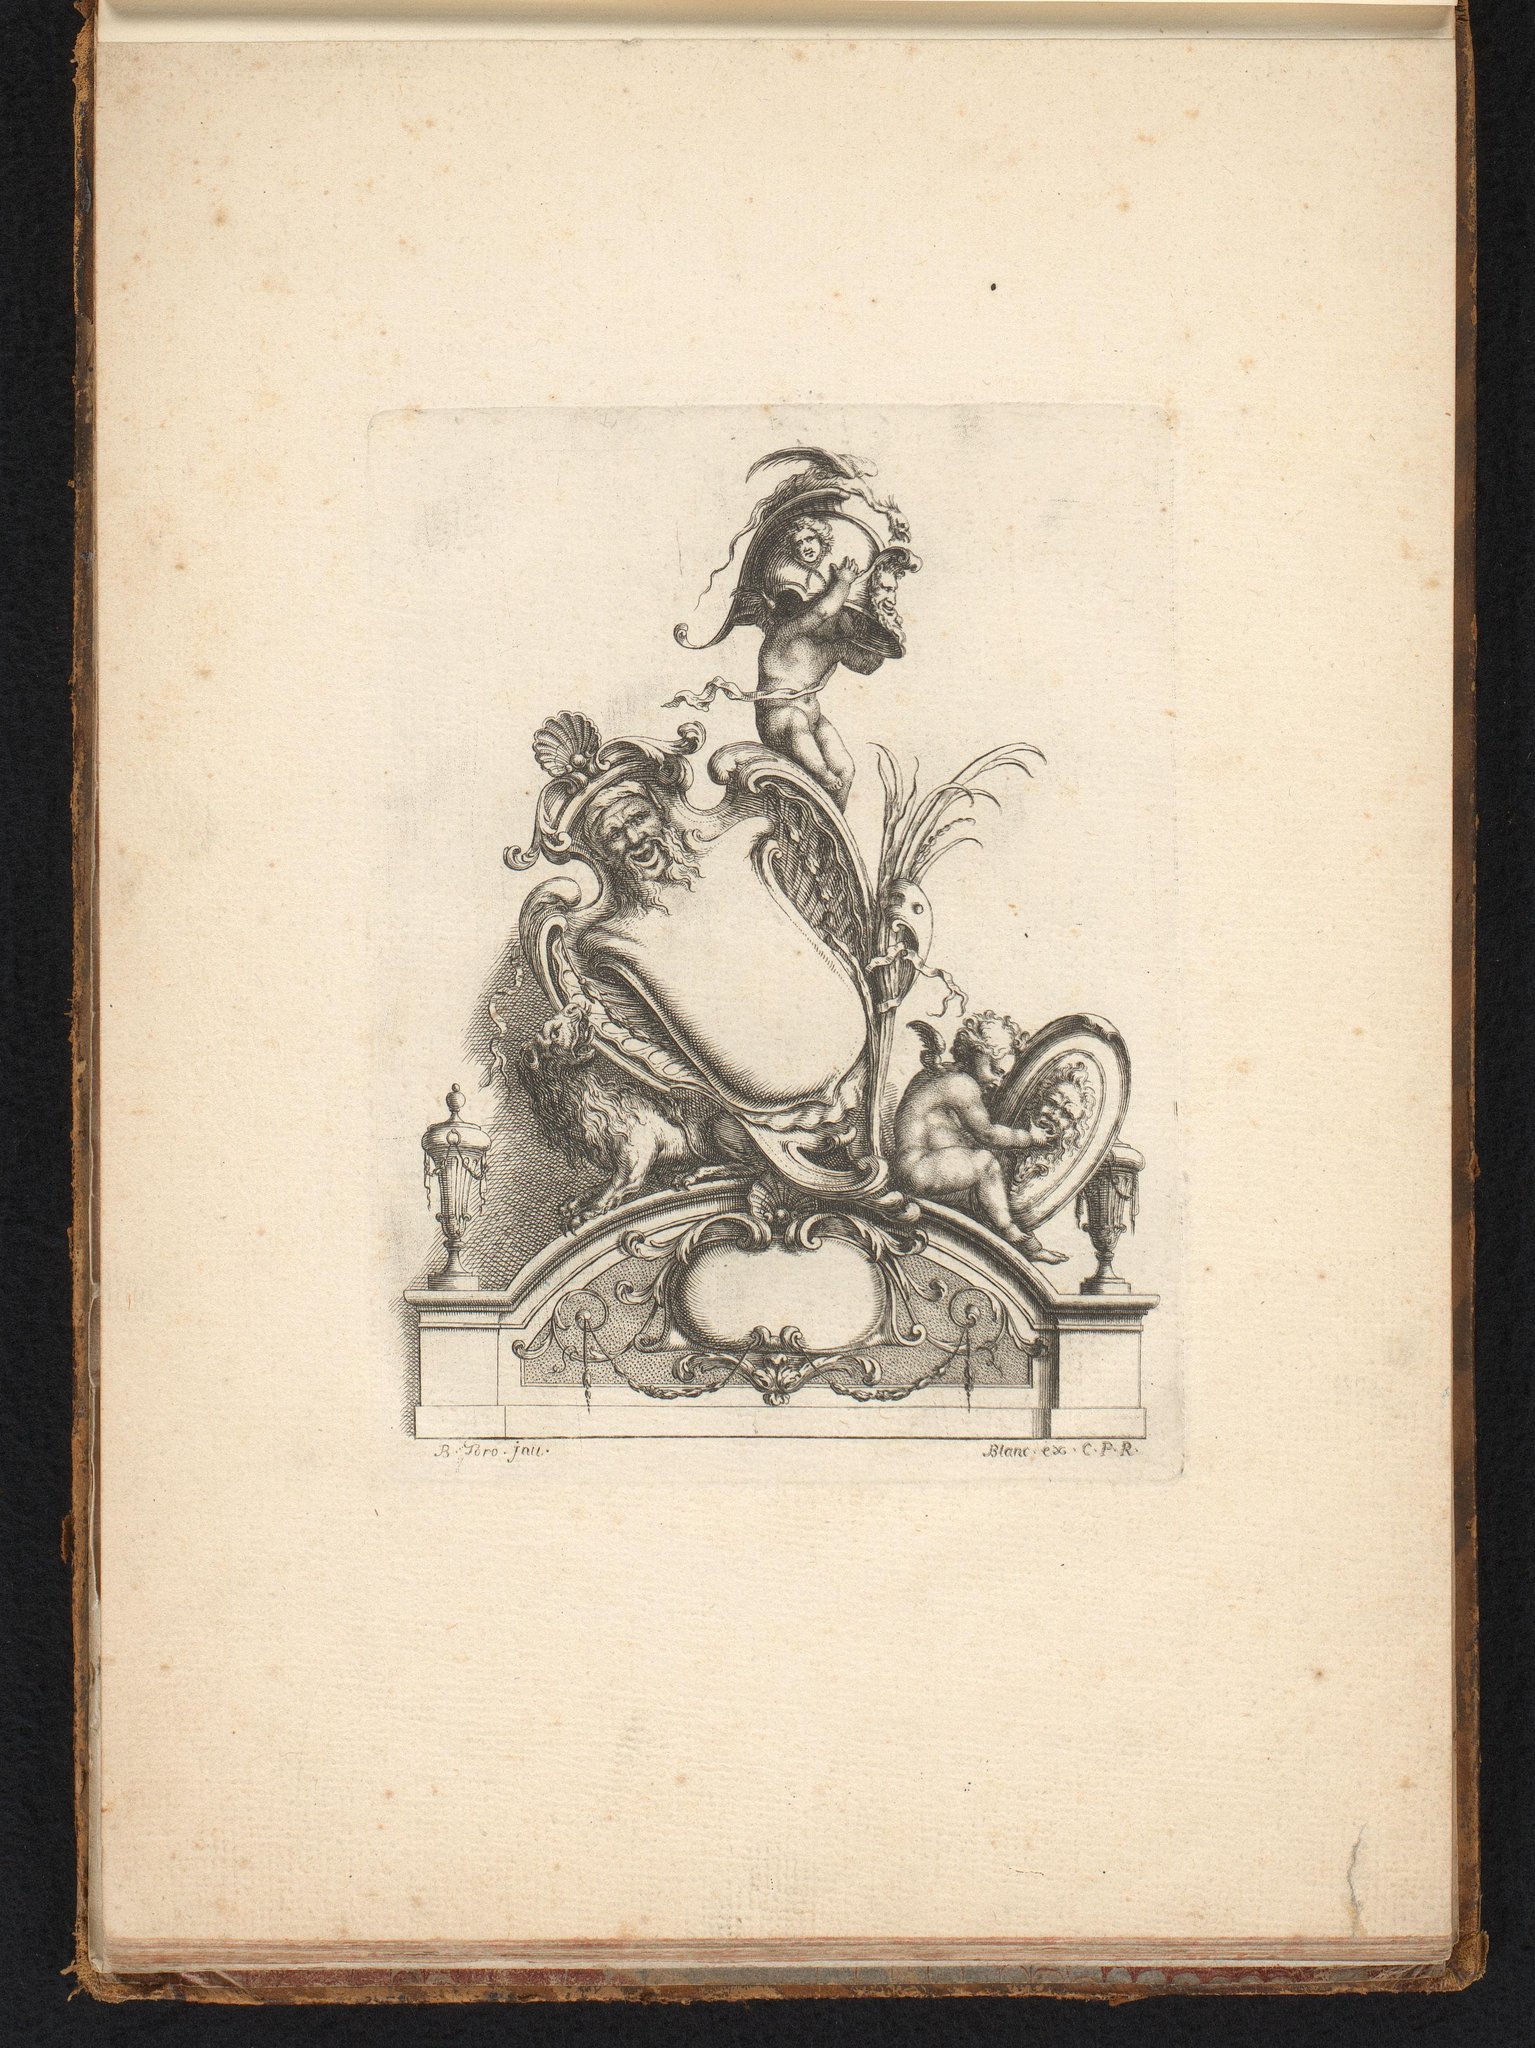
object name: album leaf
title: Ontwerpen voor cartouches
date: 1682-1729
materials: paper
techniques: engraving, etching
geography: france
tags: armour, ornament ~ cartouche, cupids: 'amores', 'amoretti', 'putti'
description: Prent maakt deel uit van een serie van zes prenten.